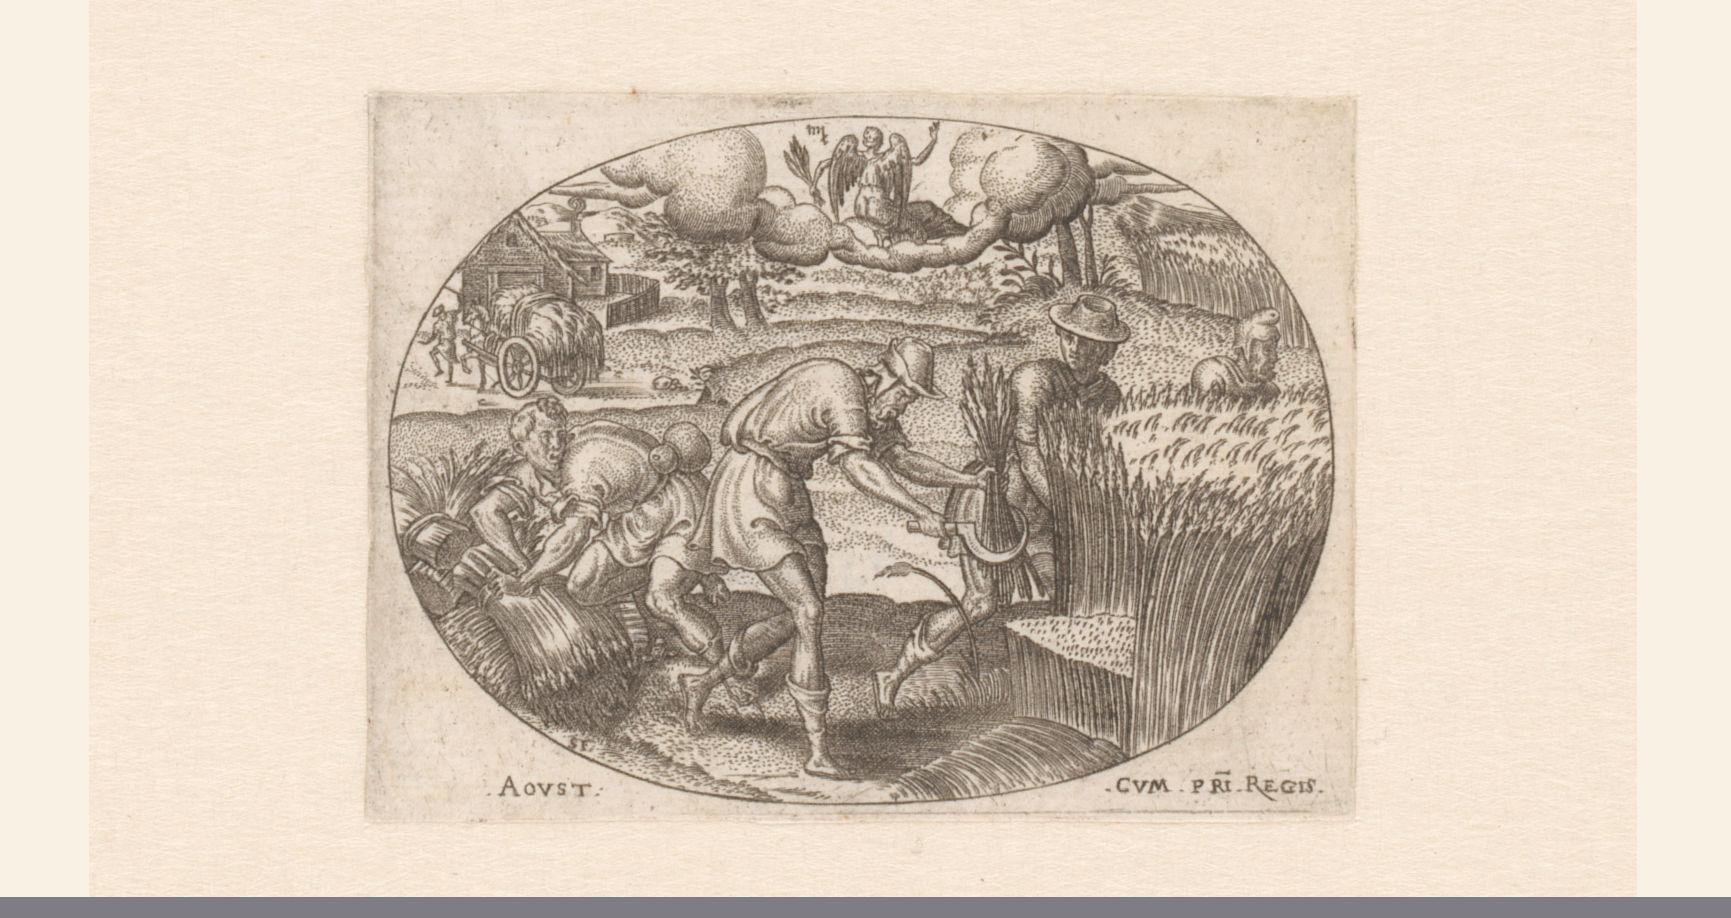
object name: print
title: Aoust.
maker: etienne delaune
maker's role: draughtsman, goldsmith, print maker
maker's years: 1519-1583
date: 1568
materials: paper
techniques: engraving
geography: france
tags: virgo (zodiacal sign of august), august and its 'labours' (+ with zodiacal signs)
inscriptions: collector's mark: Lugt 240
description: Maakt deel uit van een twaalfdelige serie van de twaalf maanden met tekens van de dierenriem, in ovale vorm. In de collectie van het Rijksmuseum bevindt zich de complete serie.